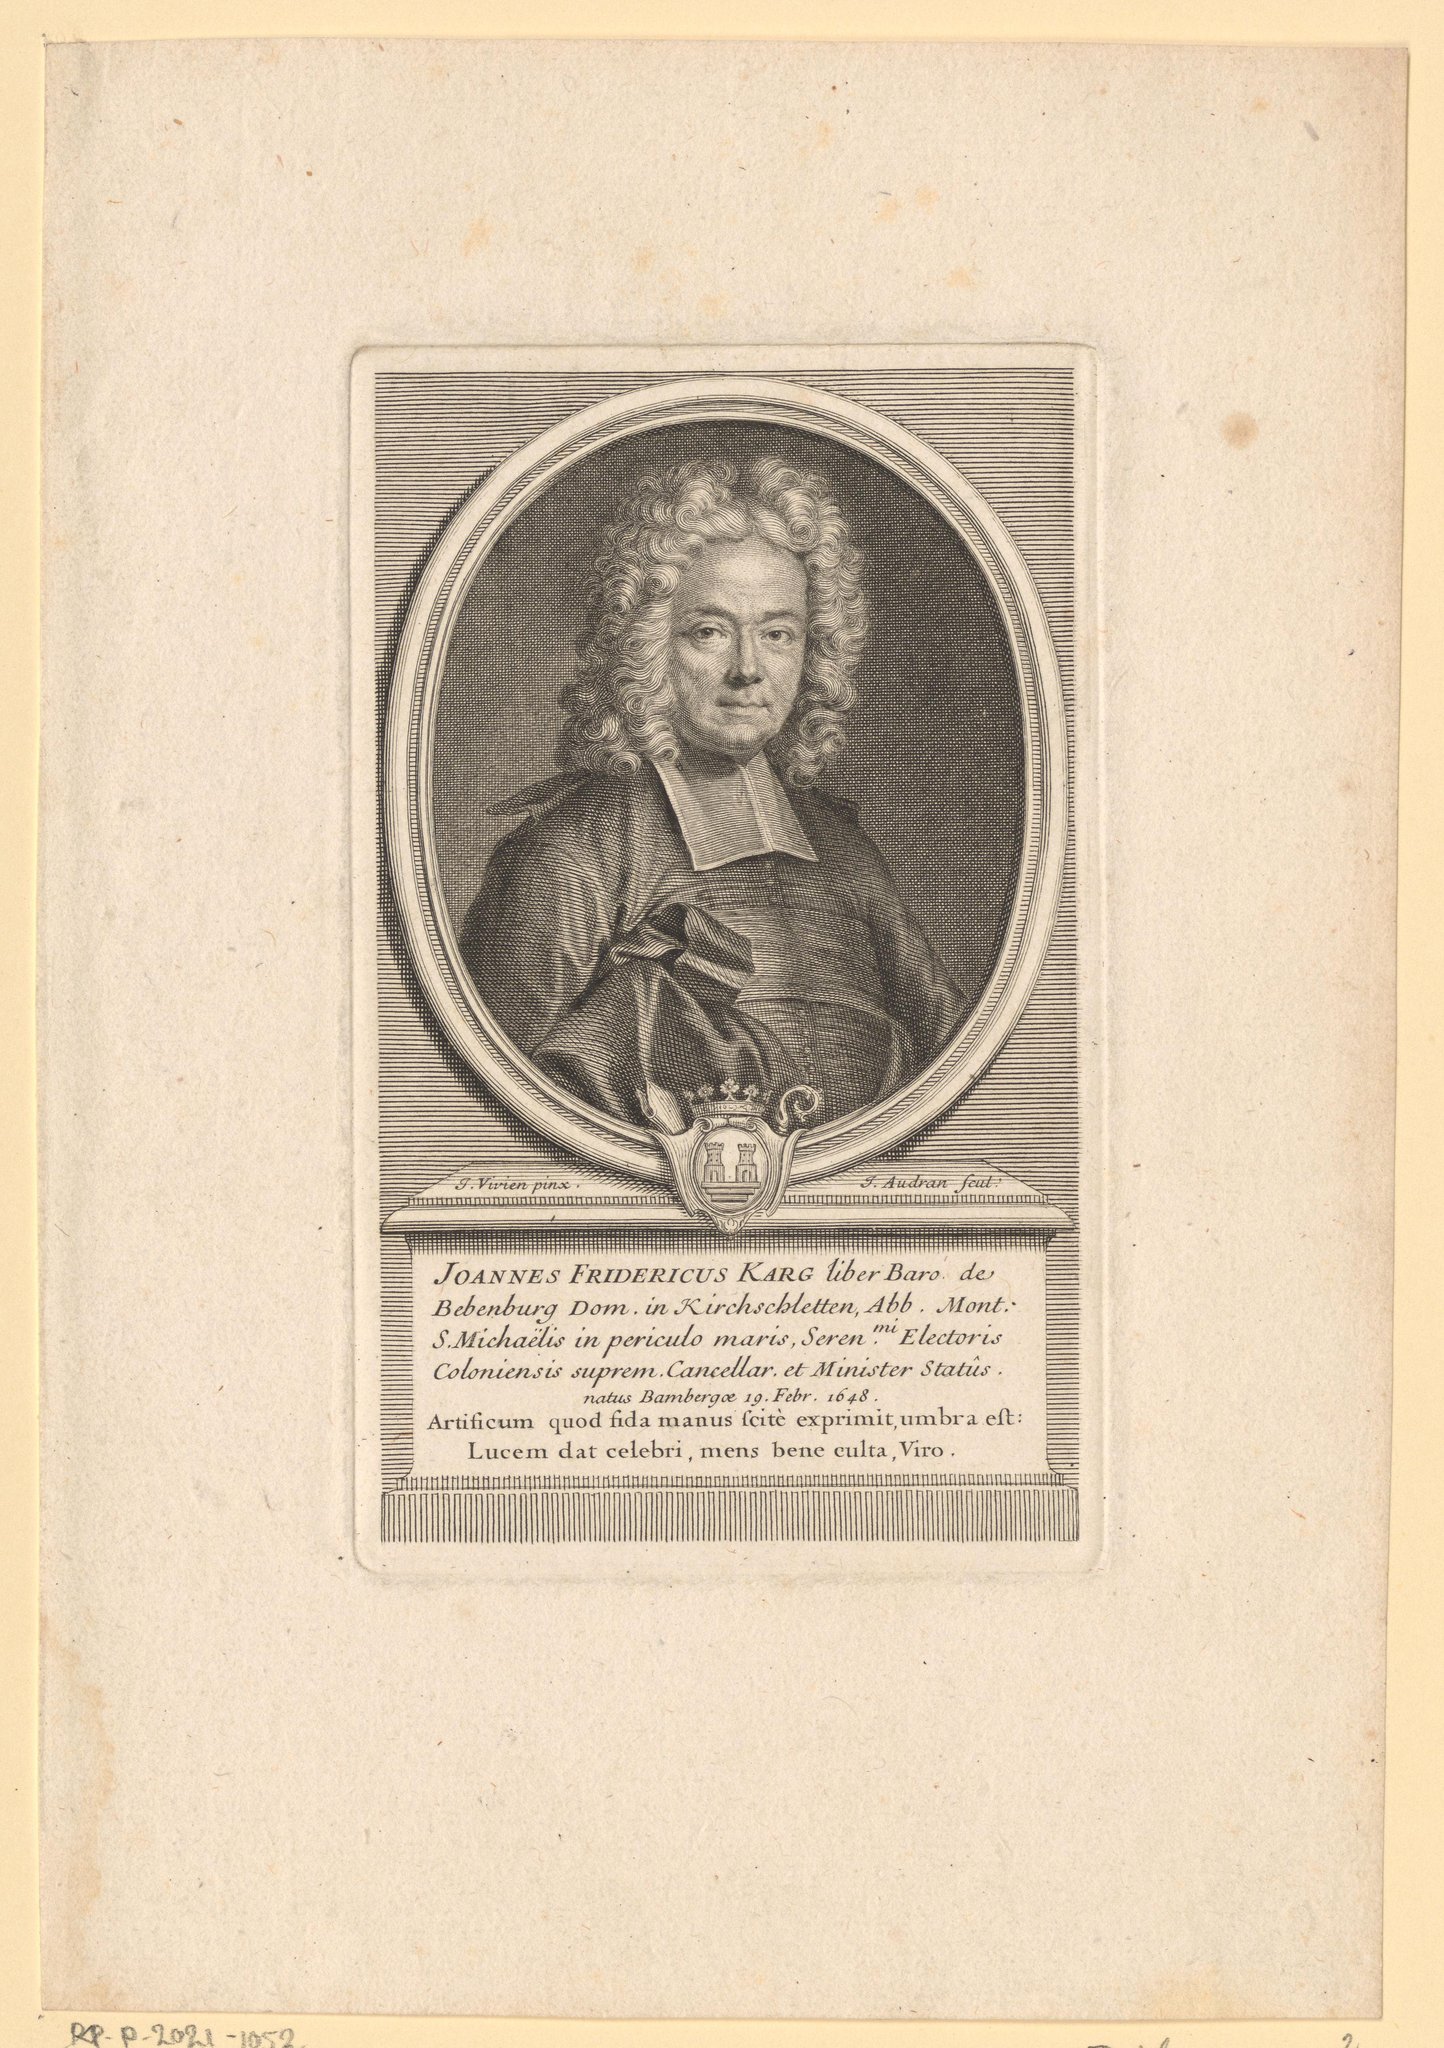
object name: print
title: Portret van Johann Friedrich Reichsfreiherr Karg von Bebenburg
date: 1678-1756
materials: paper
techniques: engraving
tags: johann friedrich reichsfreiherr karg von bebenburg, historical persons, armorial bearing, heraldry